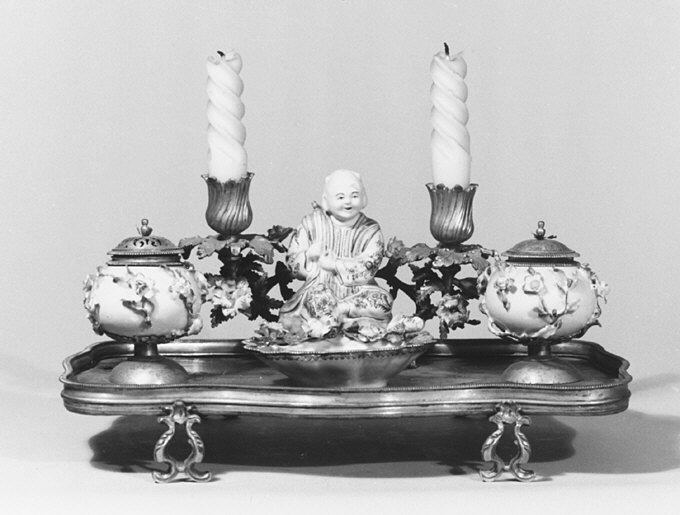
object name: inkstand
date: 1701-1900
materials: gilt bronze, glass, hard paste porcelain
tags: boys,flowers